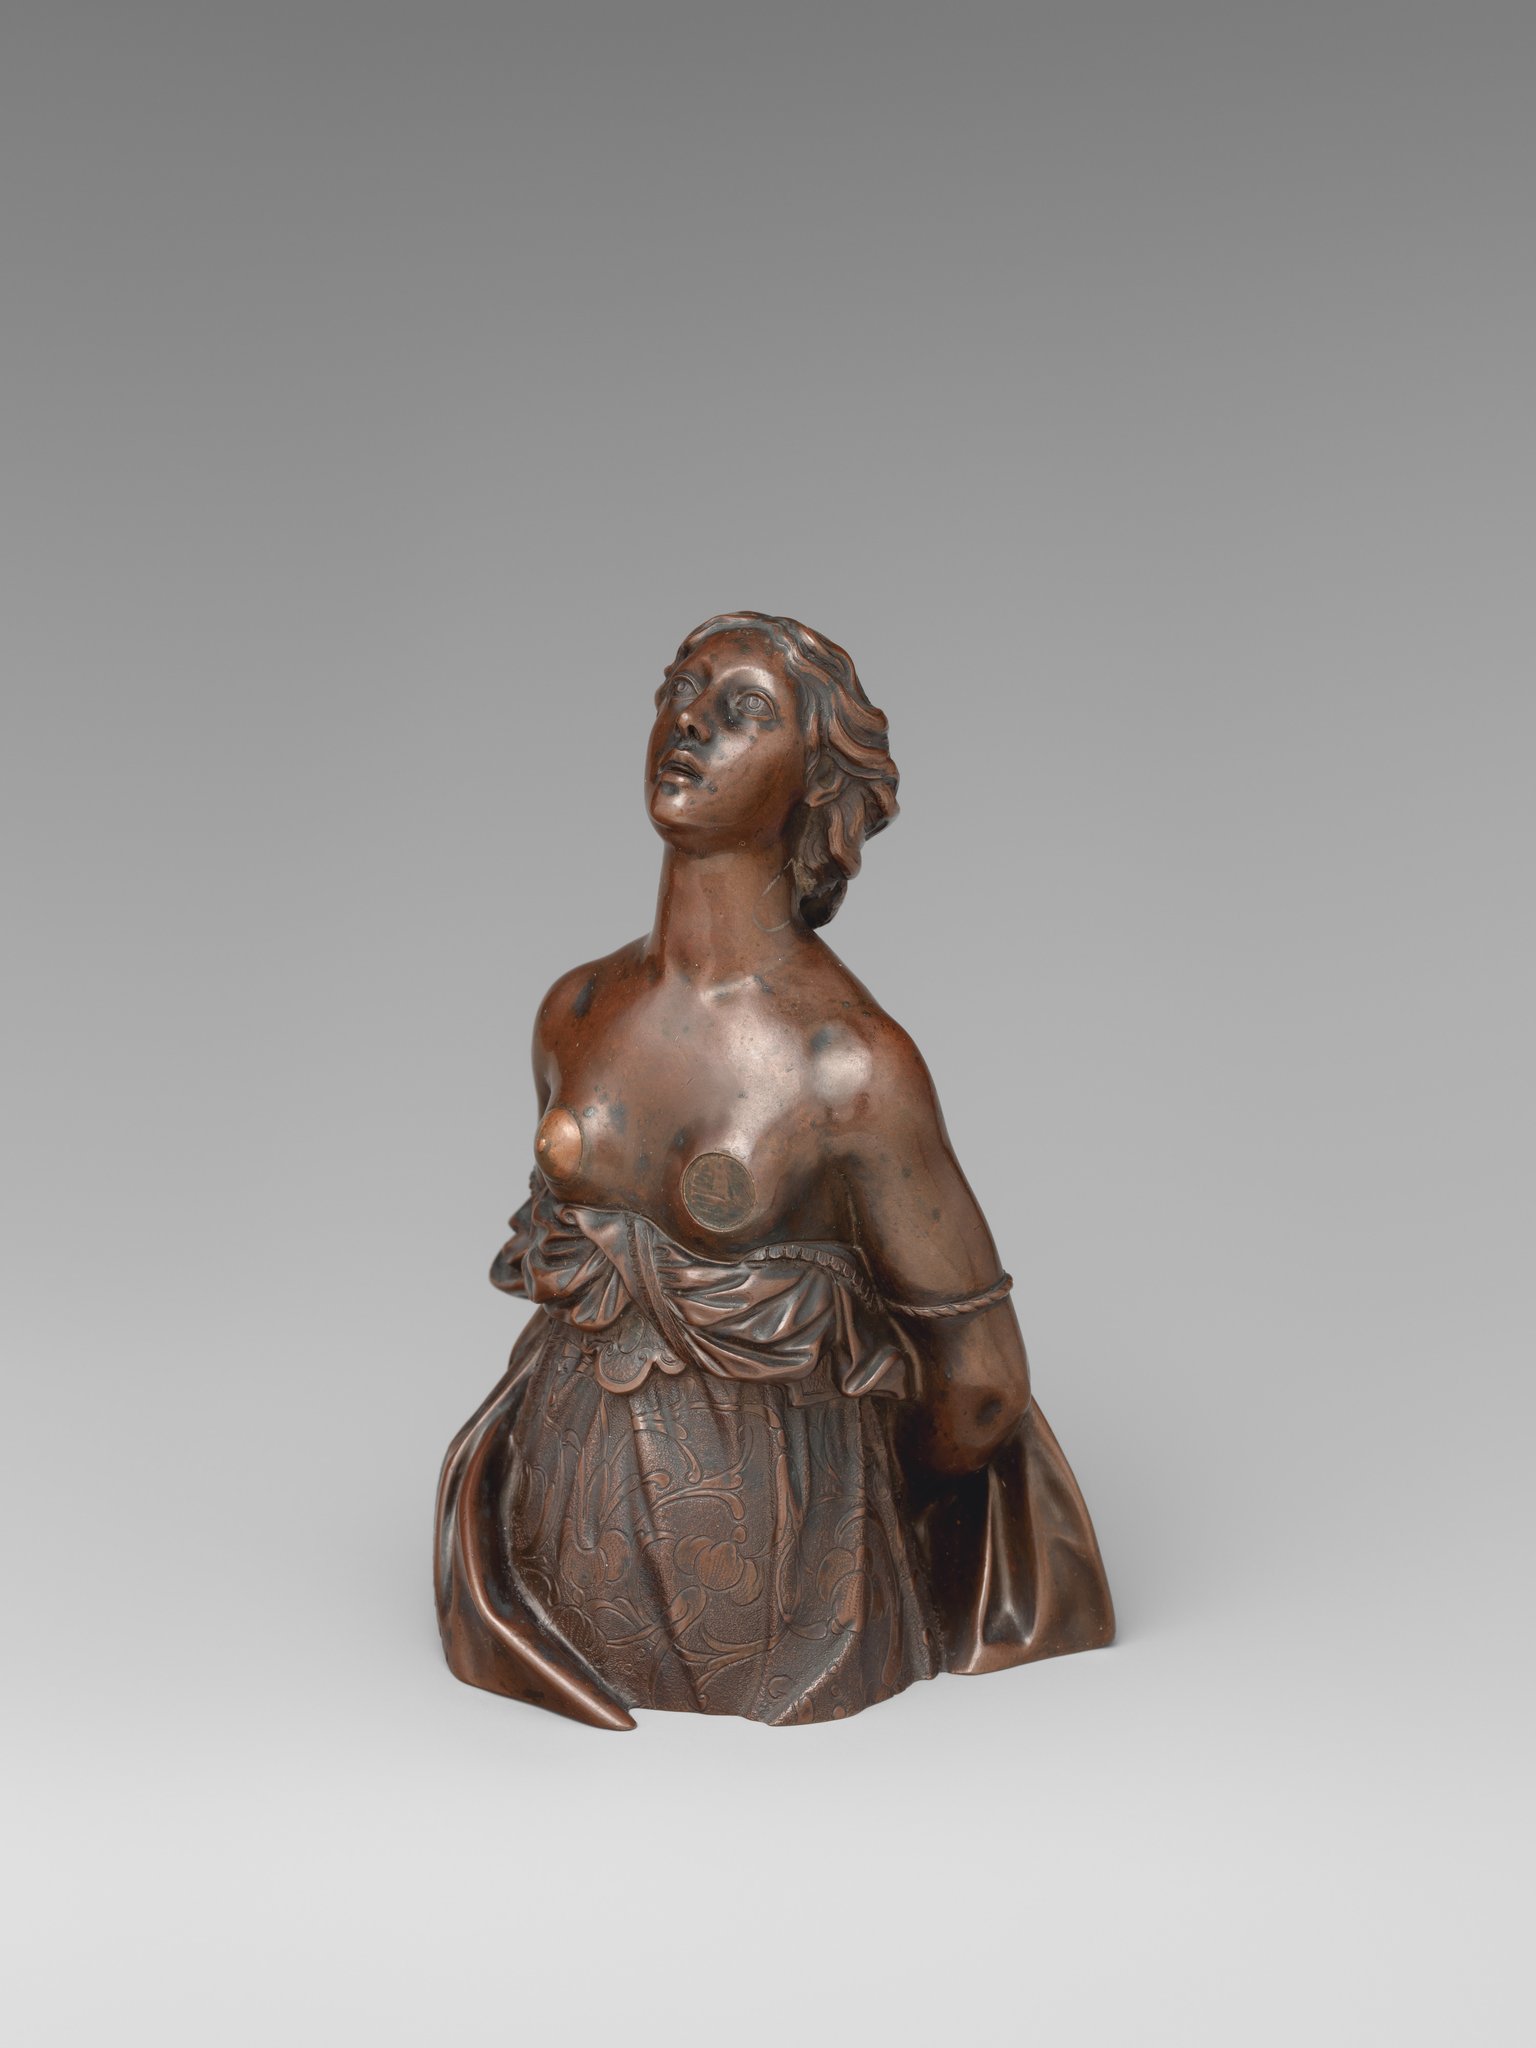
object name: statuette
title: Saint Agatha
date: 1634-1666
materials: bronze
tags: women,saints